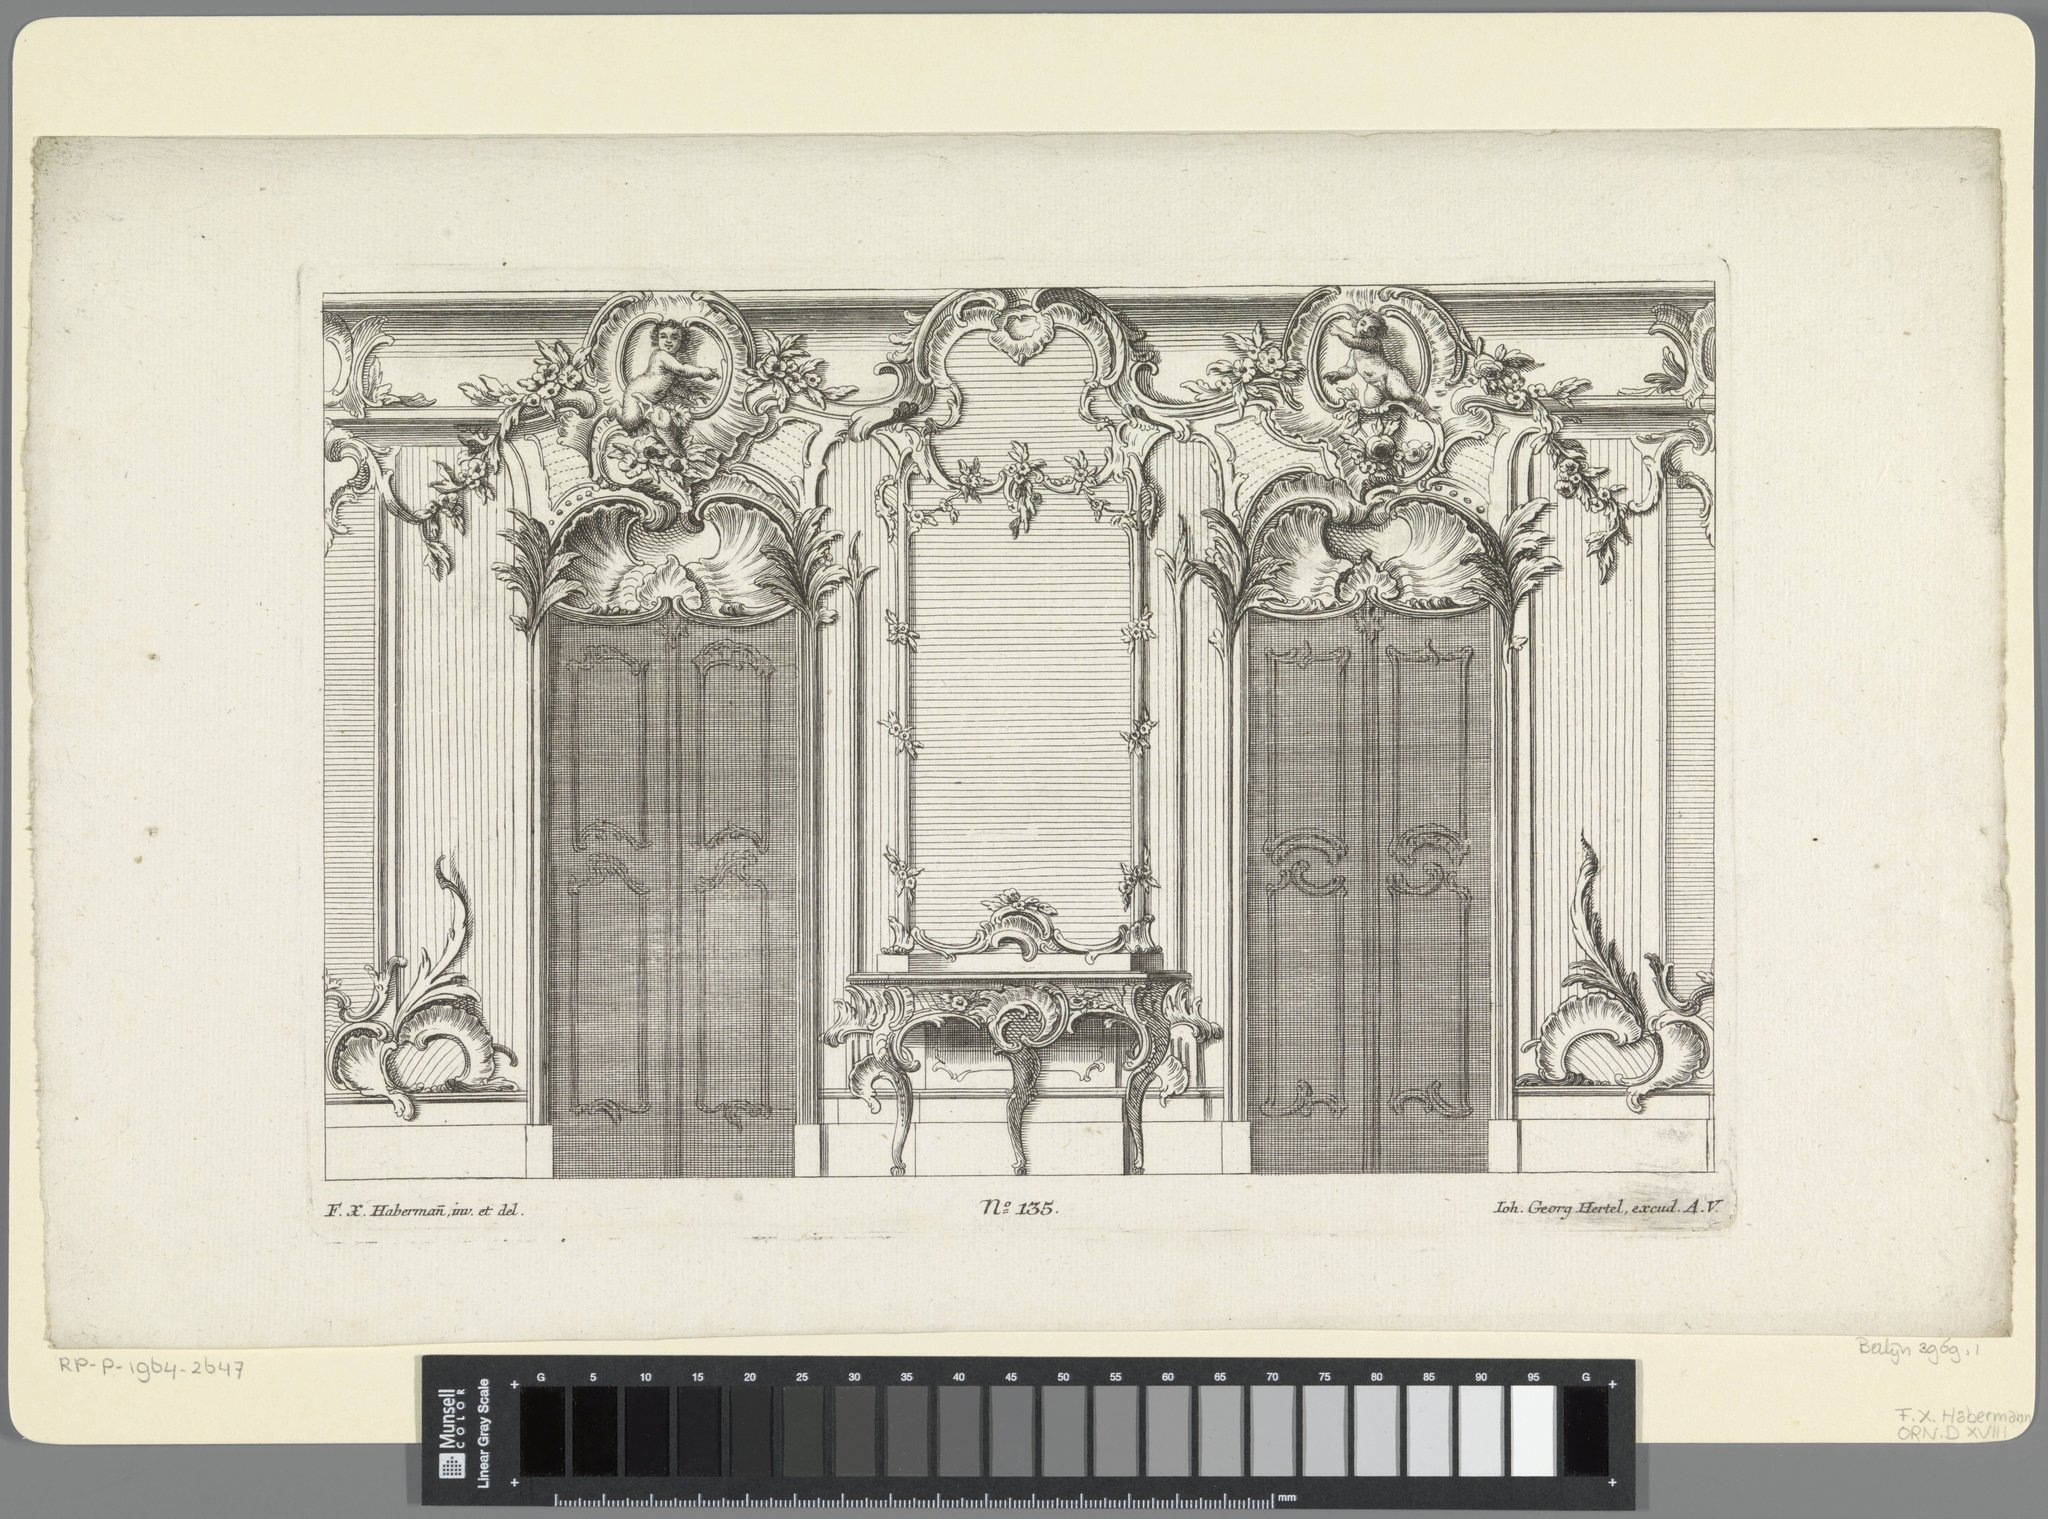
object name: ornament print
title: Wandindeling met deuren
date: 1748-1753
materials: paper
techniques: engraving, etching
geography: augsburg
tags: rocaille ornament, door, wall-covering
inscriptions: collector's mark: Lugt 2228, collector's mark: Lugt 2760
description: Wandindeling met twee deuren met rocaille omlijsting en bekroond met rocaille cartouche met putti. In het midden een met rocailles versierde tafel. Uitgeversnummer 135.